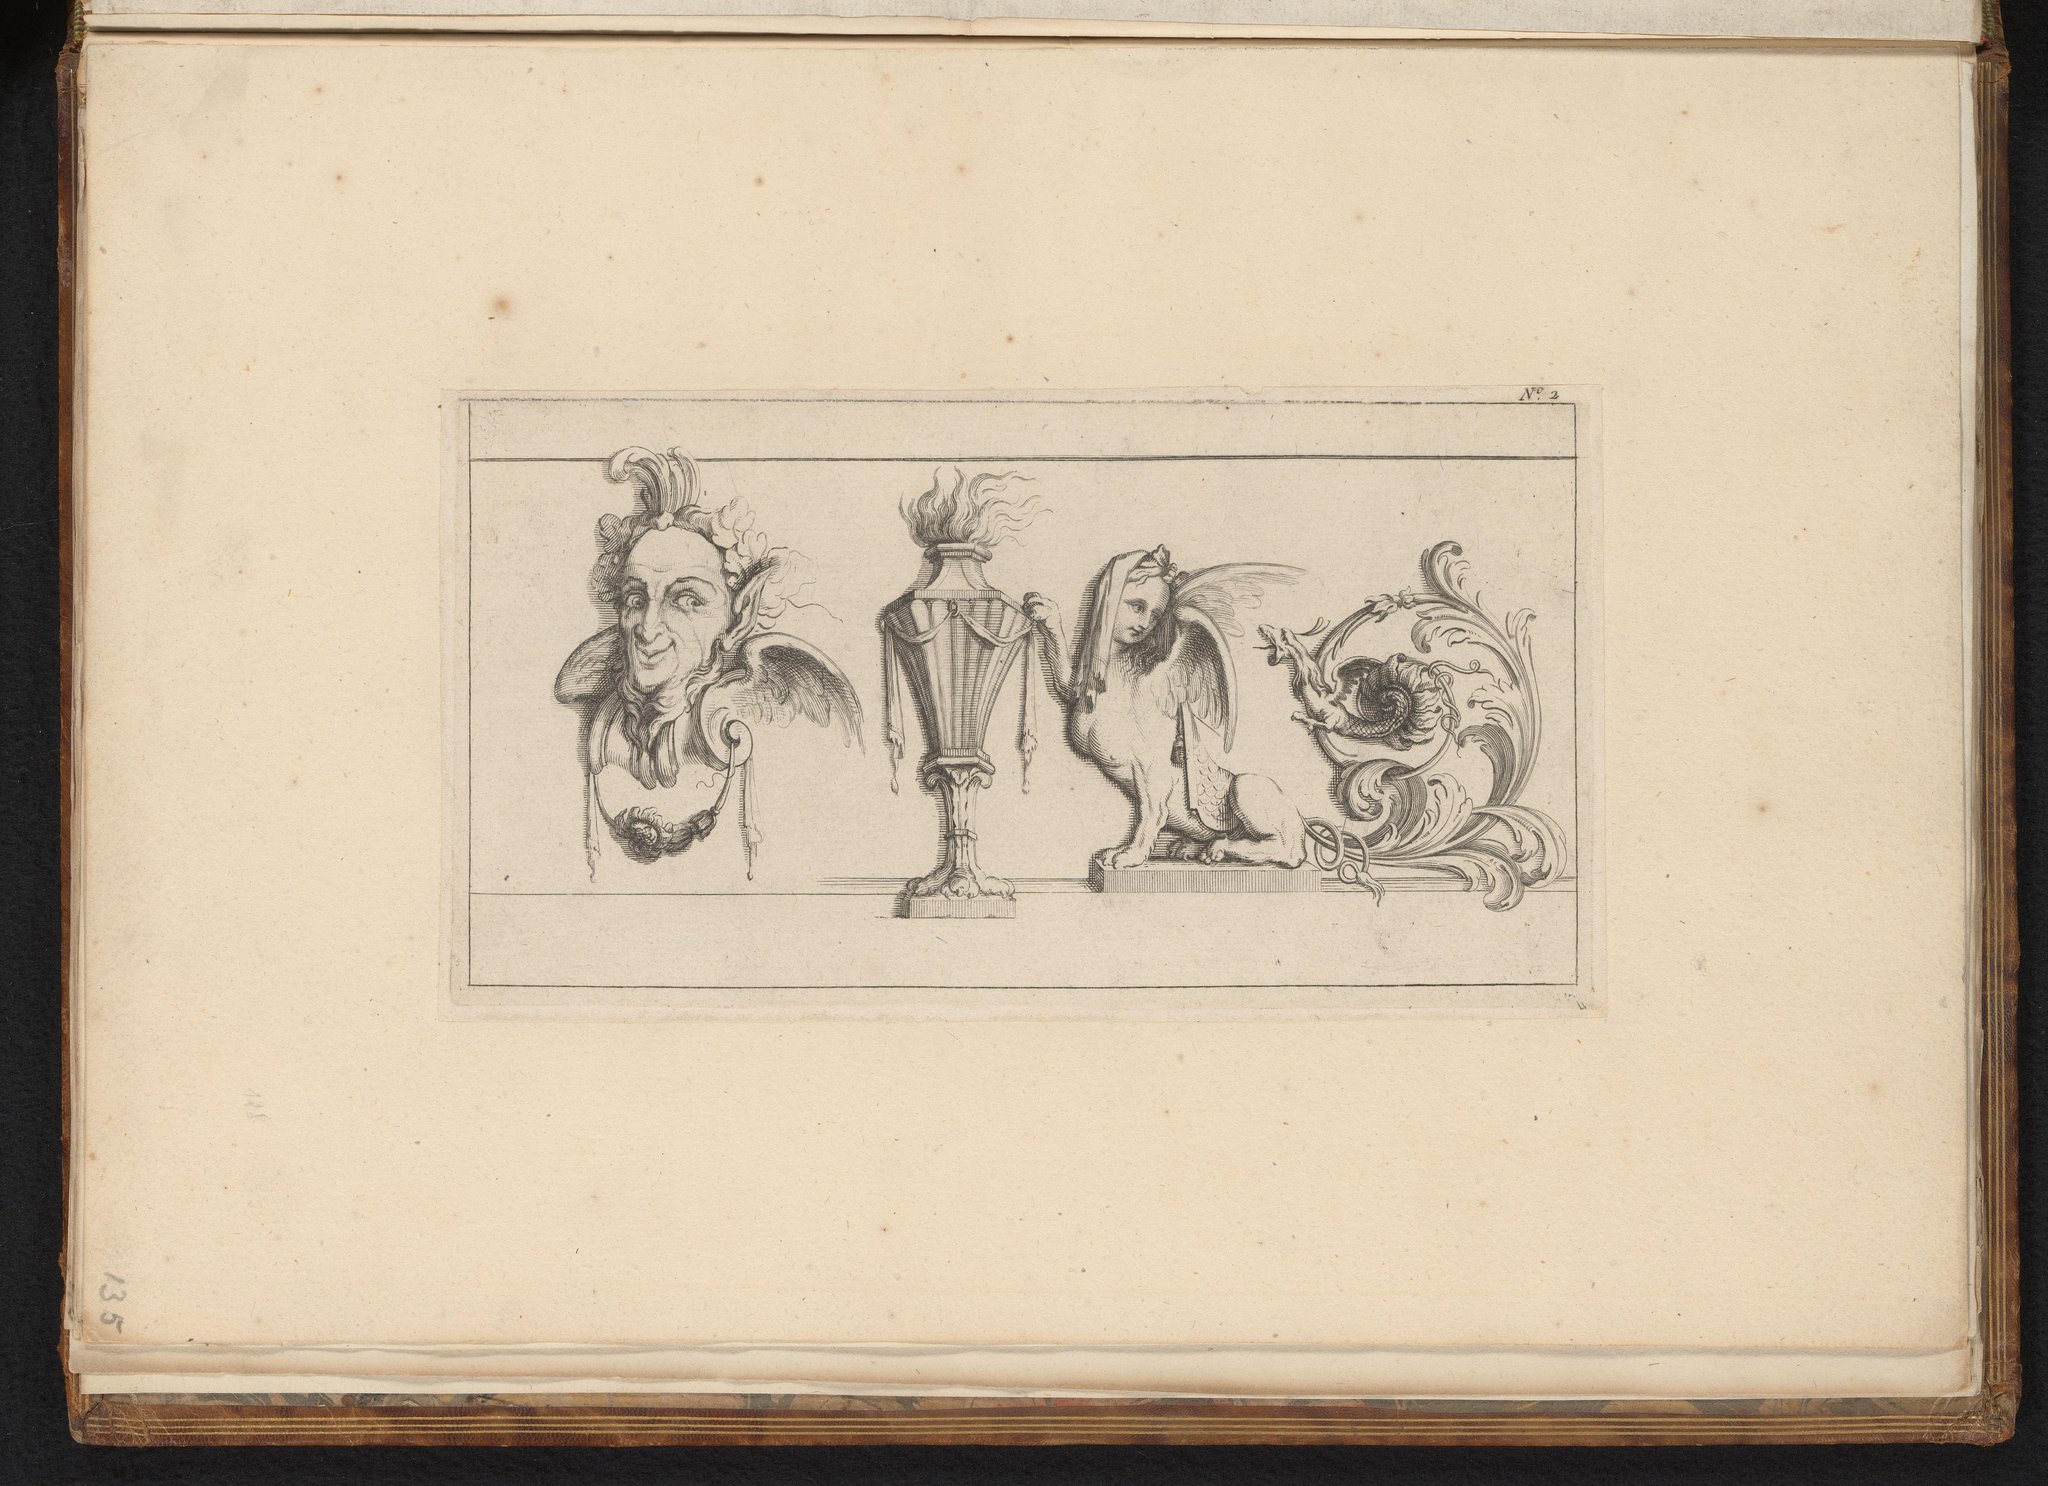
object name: album leaf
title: Friezen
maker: Anonymous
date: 1682-1723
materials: paper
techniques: etching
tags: ornament ~ grotesque, ornament ~ arabesque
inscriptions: collector's mark: Lugt 2760, collector's mark: Lugt 2228